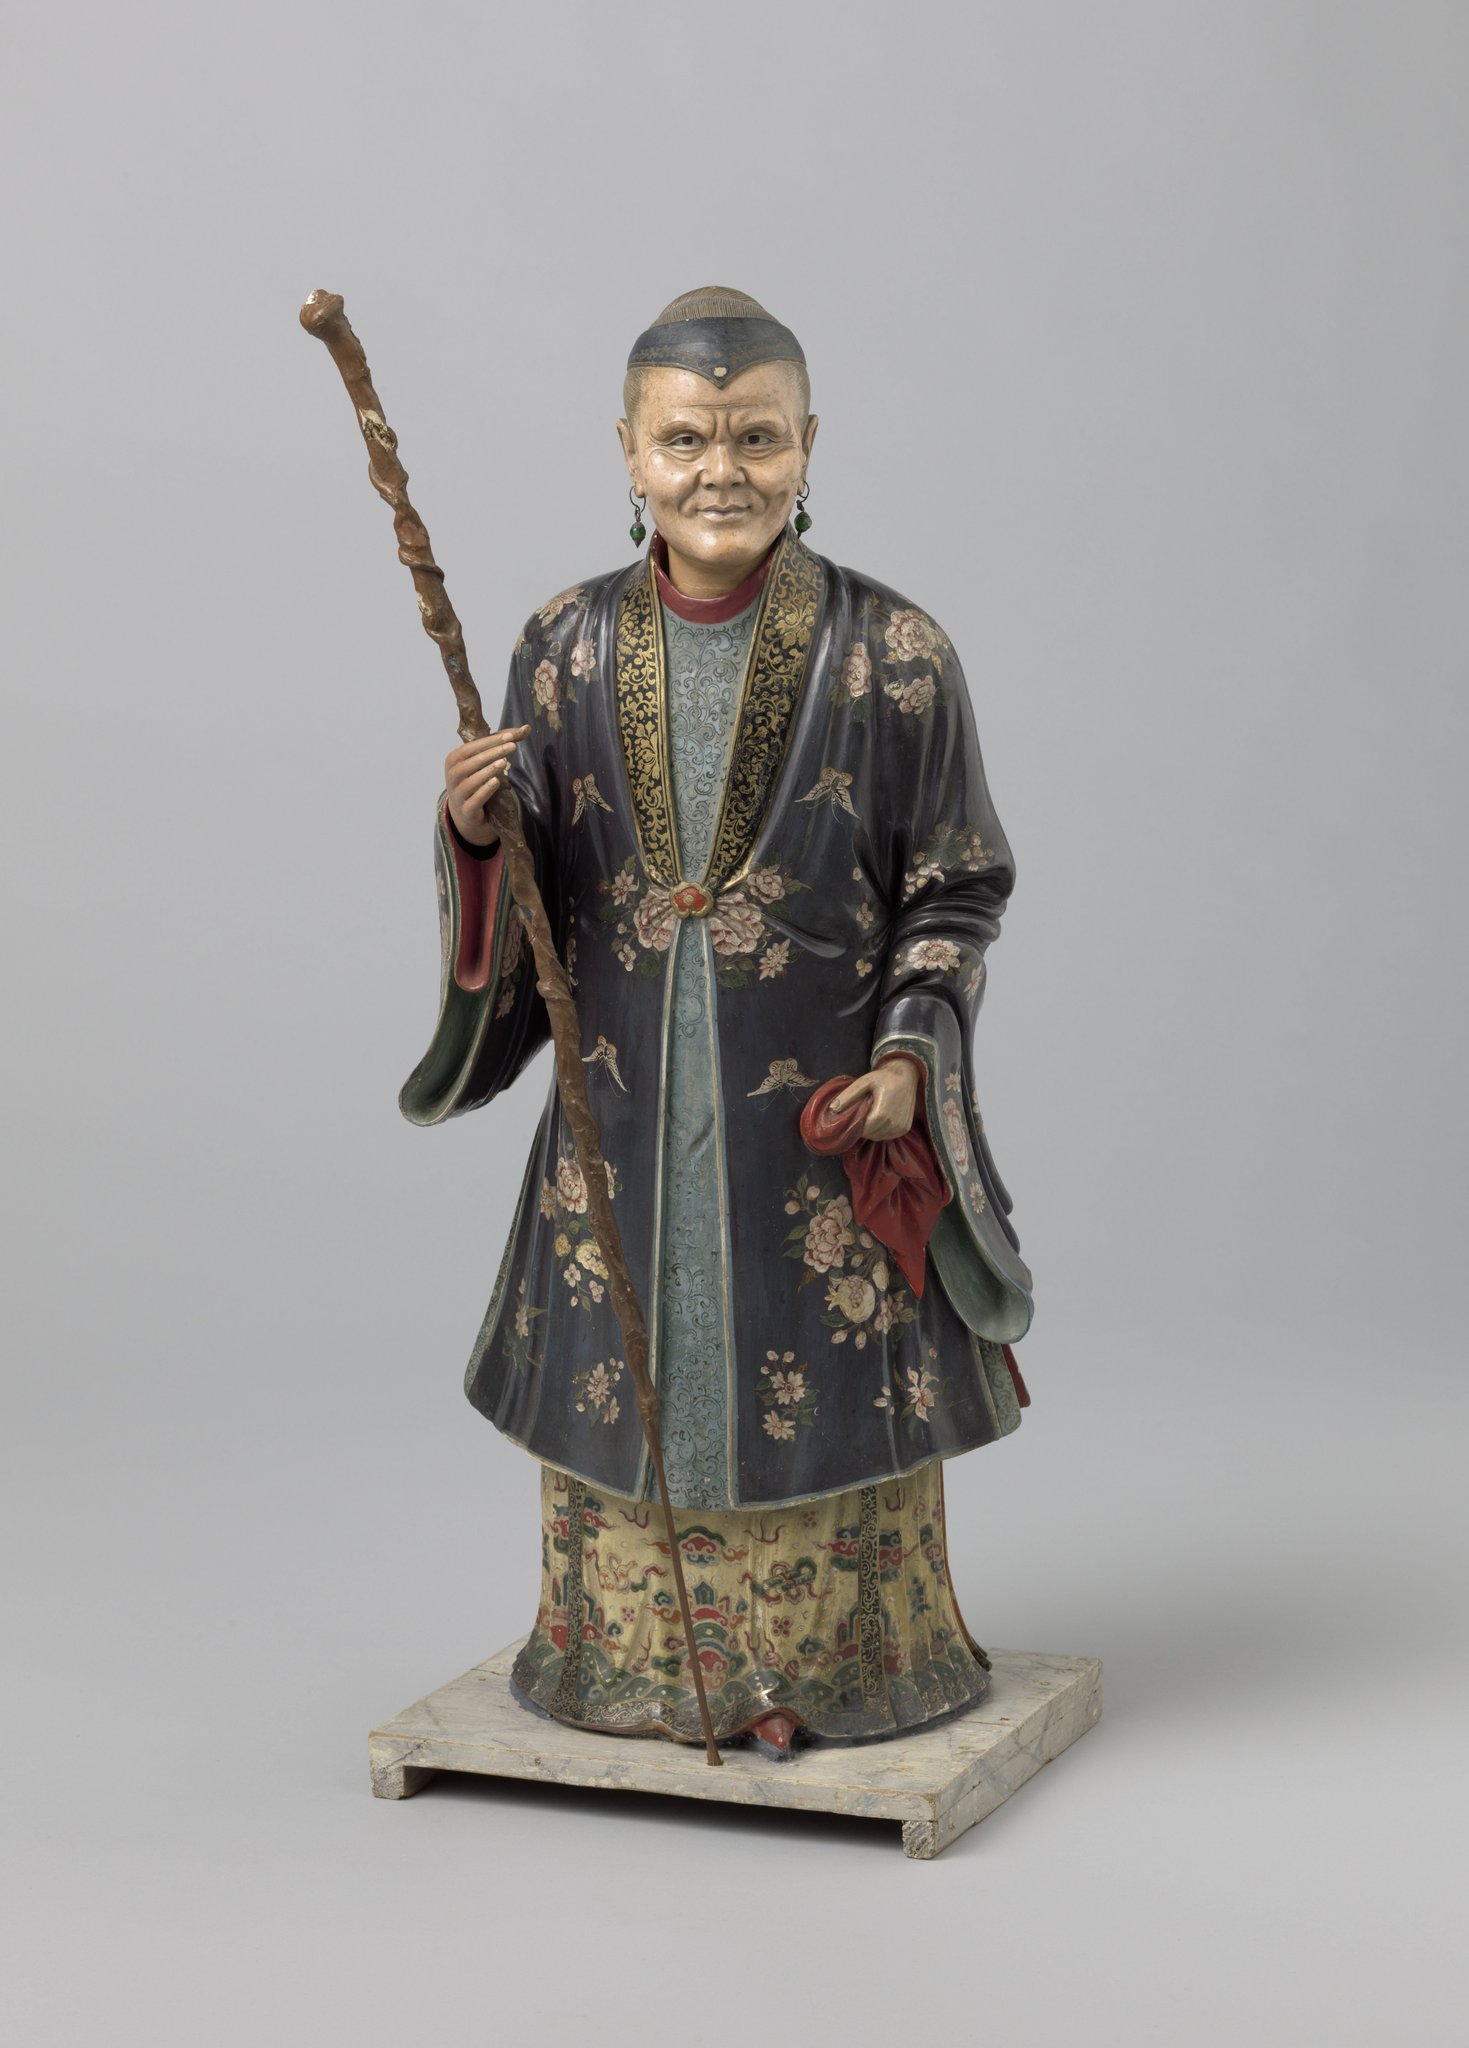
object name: doll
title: Hand van een staande Chinese knikpop (vrouw)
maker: Anonymous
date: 1804-1808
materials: glass, iron, lead, earth, porcelain, wood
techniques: woodworking, molding, polychromy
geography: china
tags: china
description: Geschenk van de Keizer van China aan A.H. van Limburg Brouwer, lid van de Raad der Aziatische Bezittingen en Etablissementen tijdens de Bataafse Republiek.